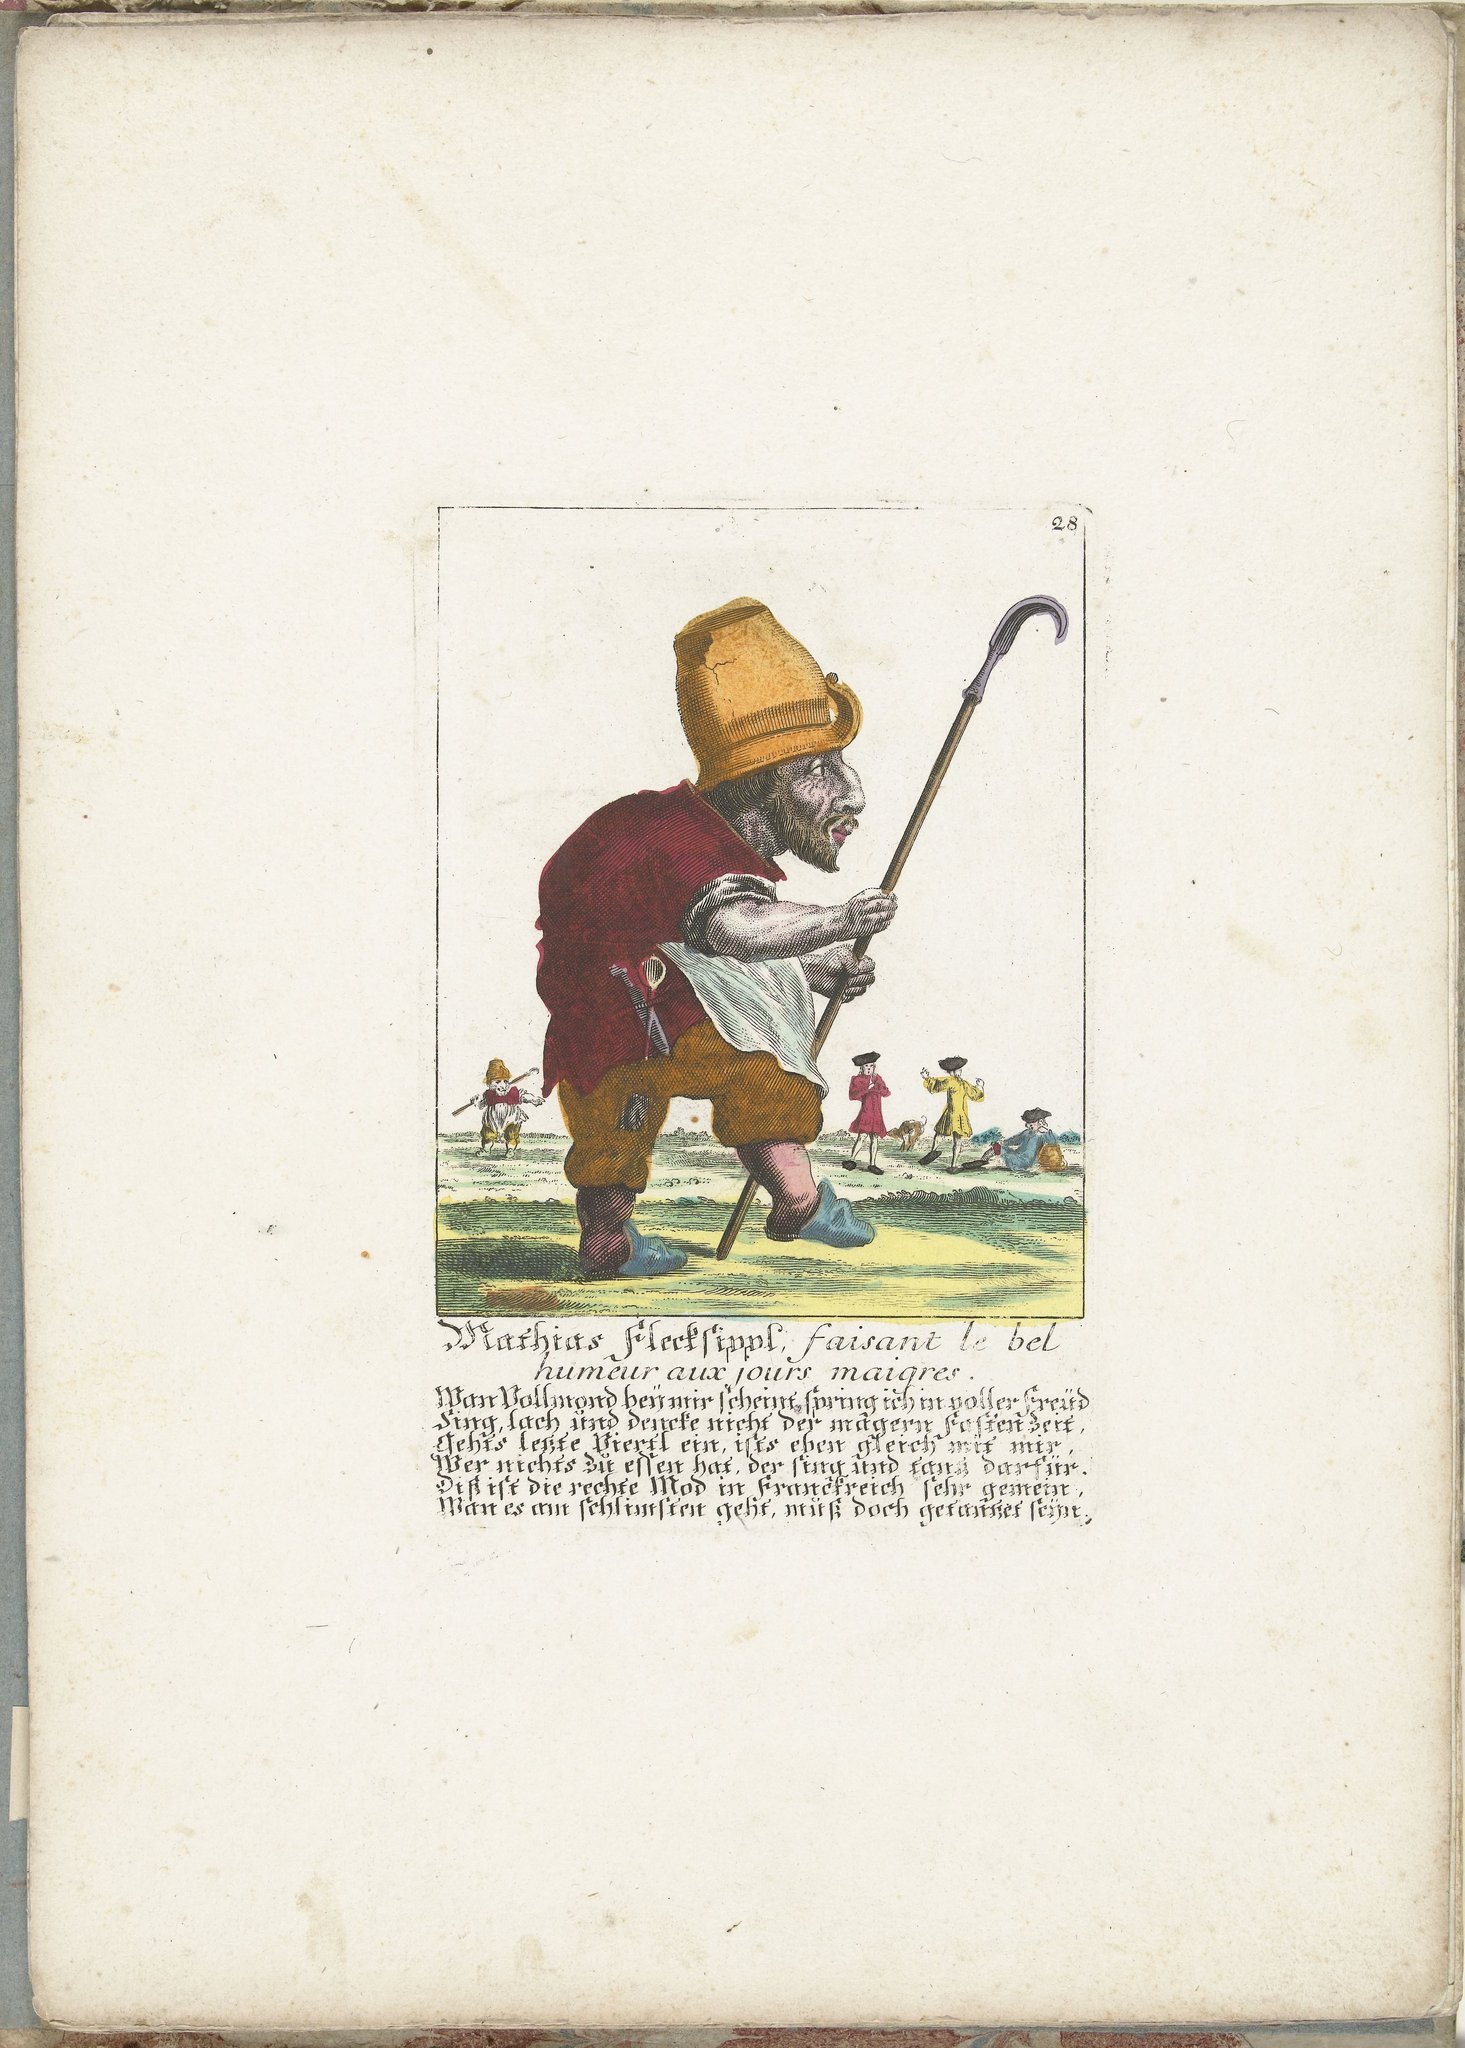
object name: caricature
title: De vrolijke kleine mens Mathias Flecksippl, ca. 1710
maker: martin engelbrecht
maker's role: print maker, publisher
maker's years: 1684-1756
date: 1705-1715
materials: paper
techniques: engraving, etching, hand coloring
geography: augsburg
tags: caricatures (human types), little people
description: De vrolijke kleine mens Mathias Flecksippl met herdersstaf en een aardewerken kruik op het hoofd. In het onderschrift onder de titel een zesregelig vers in het Duits. Genummerd rechtsboven: 28. Onderdeel van een losbladige uitgave uit ca. 1710 van een serie karikaturen van kleine mensen, bekend als Het Dwergentooneel.